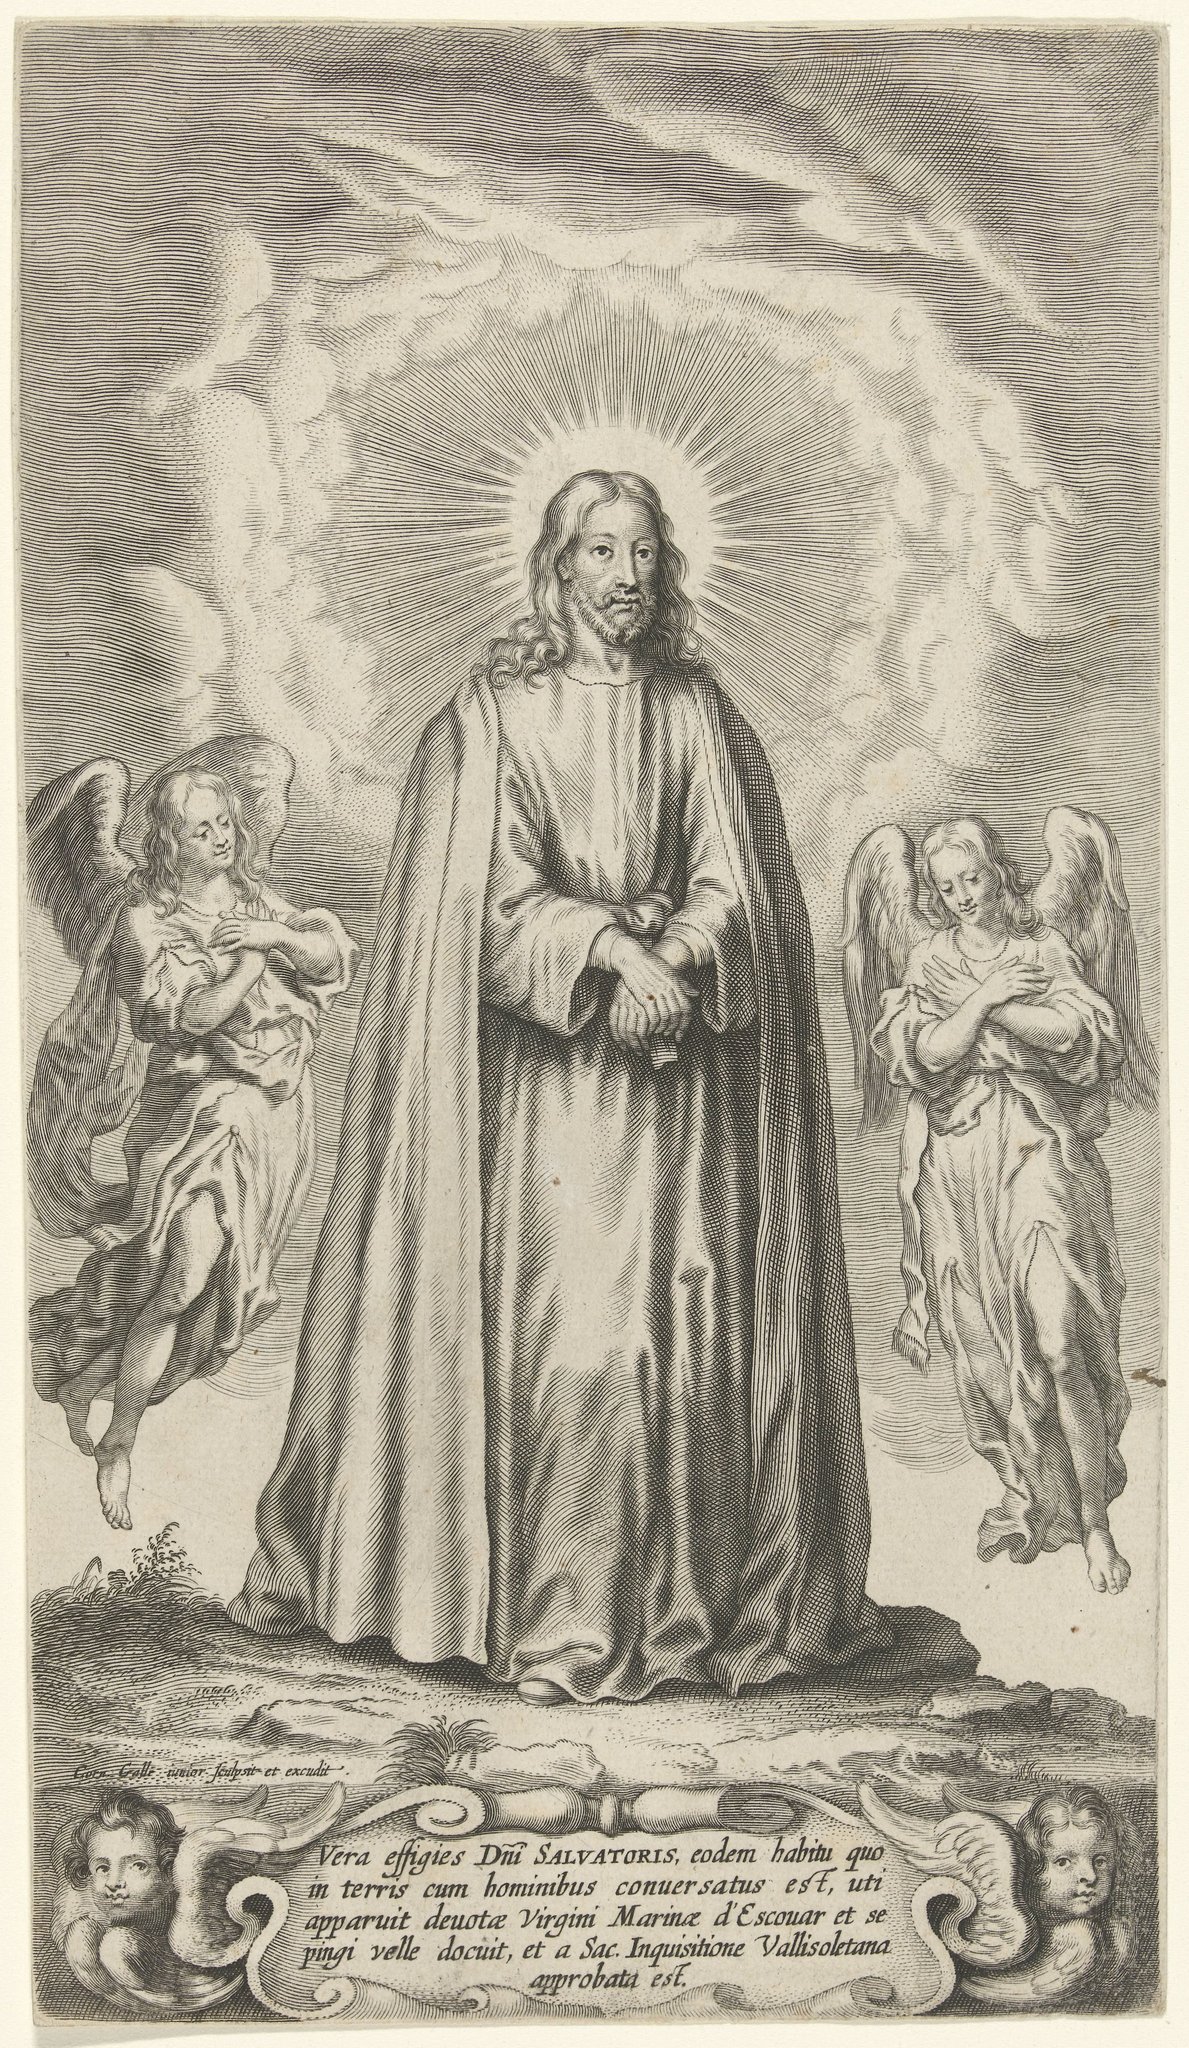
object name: print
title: Christus met twee engelen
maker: cornelis galle (ii)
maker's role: print maker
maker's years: 1615-1678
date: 1638-1650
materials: paper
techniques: engraving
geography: antwerp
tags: particular types of adult christ (without others) (+ angel(s))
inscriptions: collector's mark: Lugt 2760, collector's mark: Lugt 2228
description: Christus staand met een wijde mantel aan. Hij kruist zijn handen. Aan weerszijden engelen met gekruiste armen. Onder een cartouche met een Latijnse tekst.